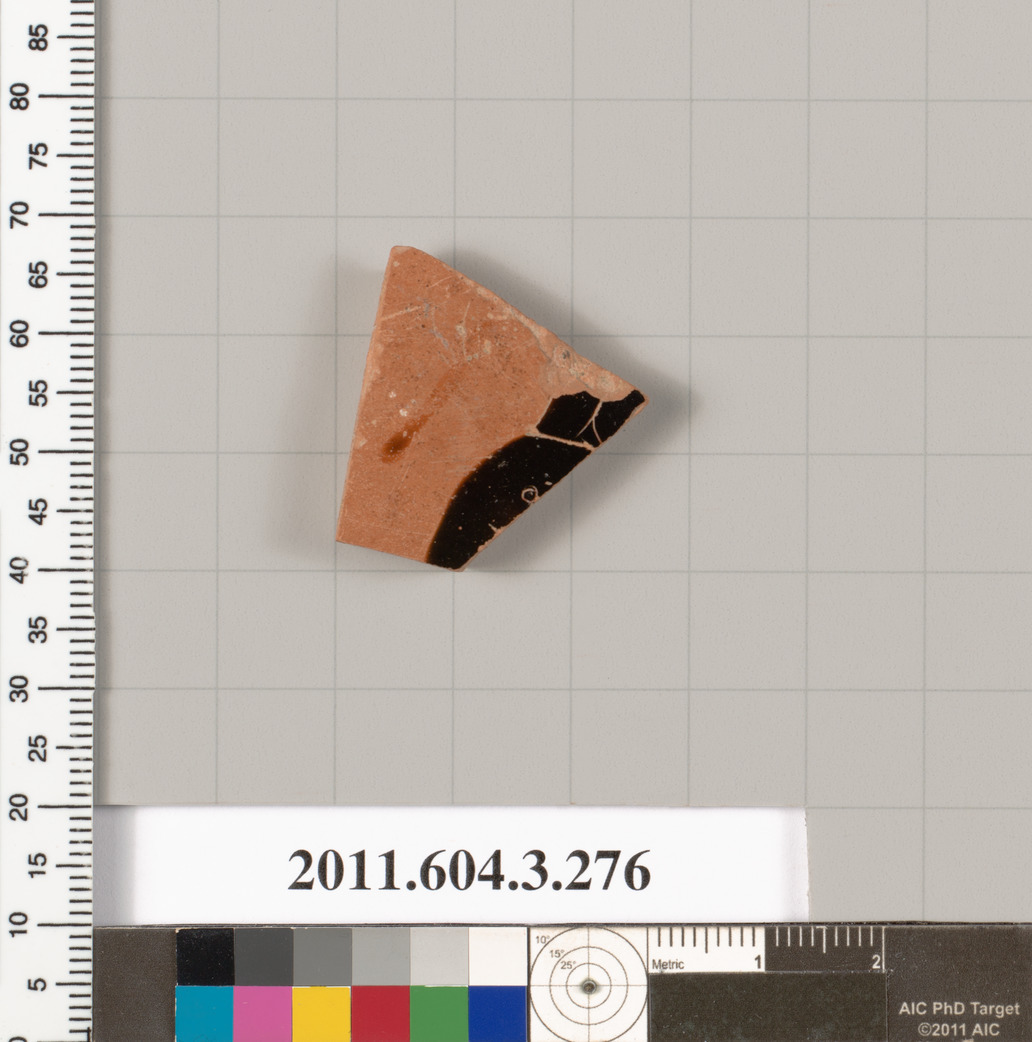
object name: neck amphora fragment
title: Terracotta fragment of a neck-amphora (jar)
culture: greek, attic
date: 534-468 BCE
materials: terracotta